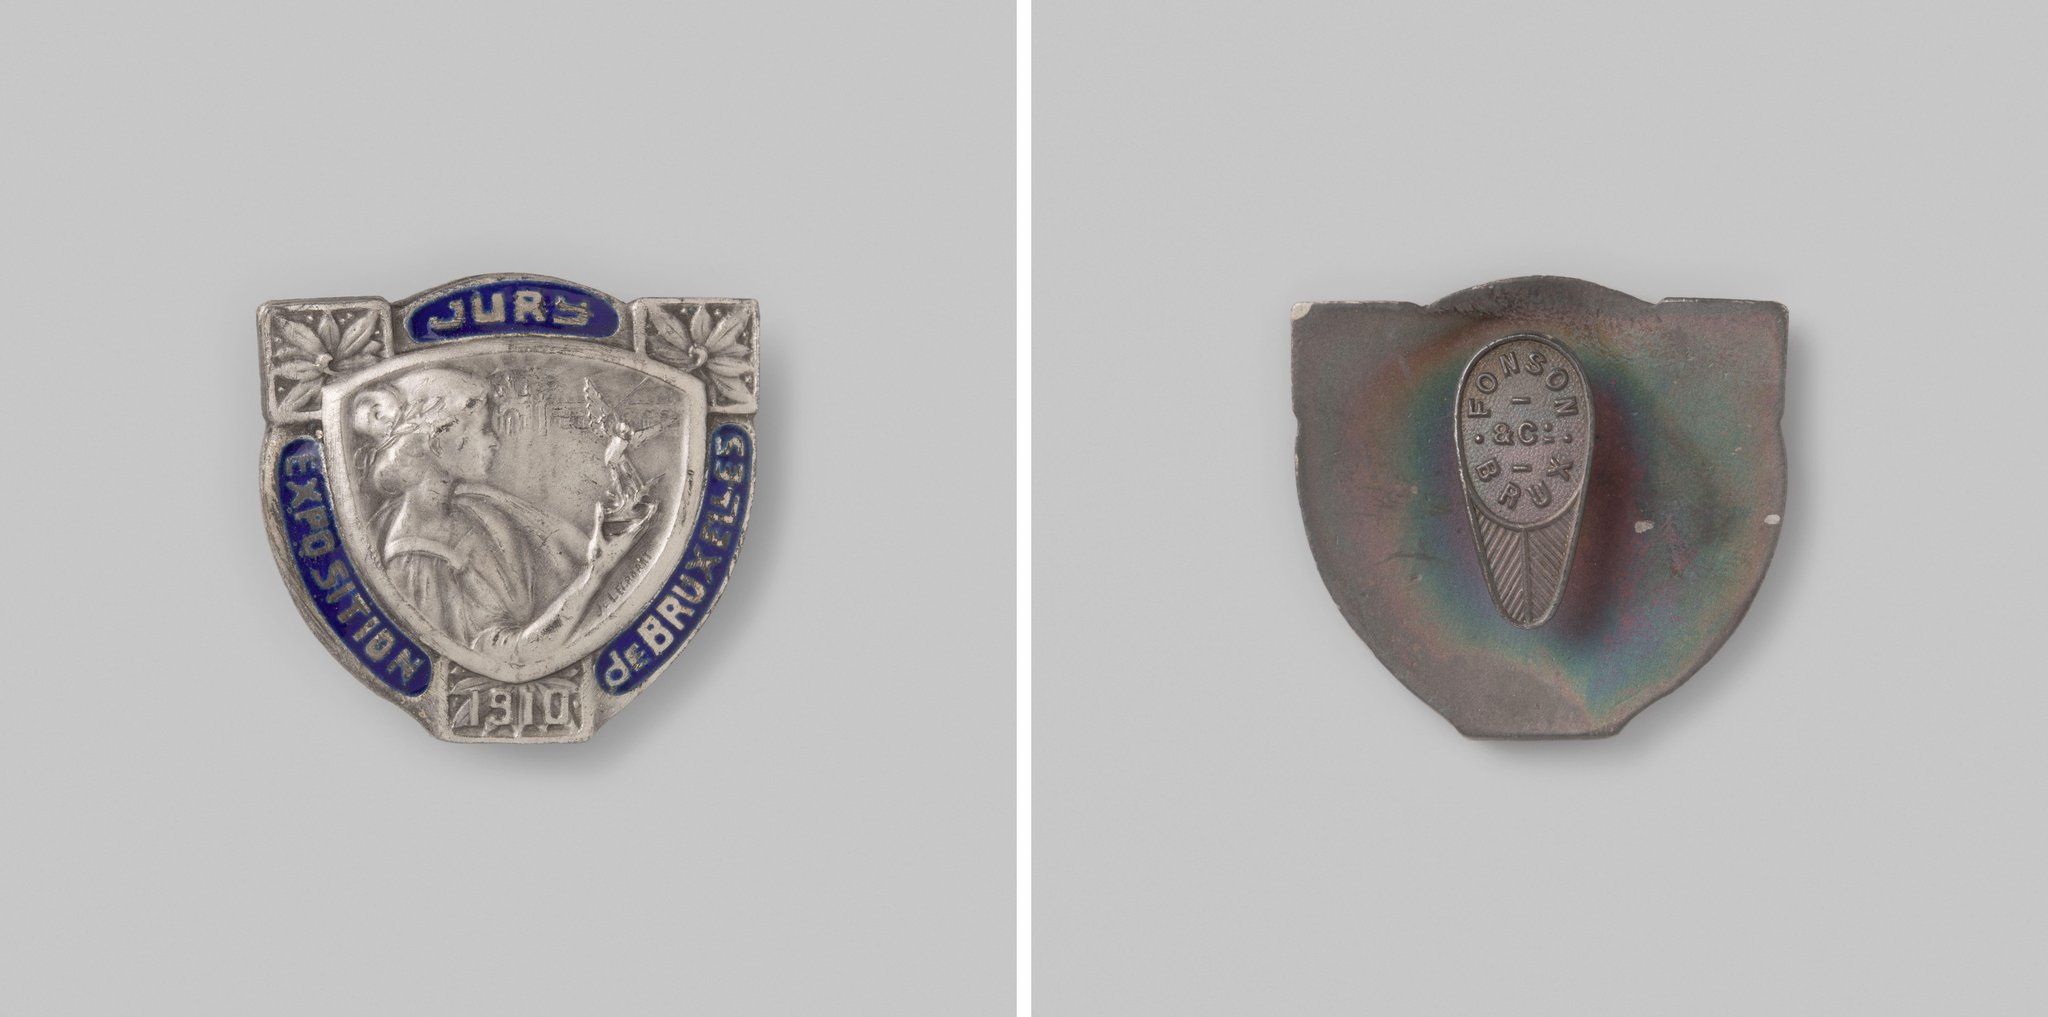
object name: insignia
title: Draagteken uitgereikt aan Bart van Hove, een van de juryleden van de Wereldtentoonstelling te Brussel, 1910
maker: jean lecroart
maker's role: medailleur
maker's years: 1883-1967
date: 1910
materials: silver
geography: belgium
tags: the hague, amsterdam, sculptor, bart van hove, brussels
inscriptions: signature: ‘J. LECROART’, inscription: ‘JURY EXPOSITION DE BRUXELLES 1910’, inscription: ‘FONSON .&c;. BRUX’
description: Penning in vorm halve ovaal. Voorzijde: in midden binnen omlijsting borstfiguur van naar rechts gekeerde vrouw in profiel die in rechterhand beeldje van gevleugelde ridder (Sint Joris) vasthoudt, met op de achtergrond een gebouw; in bovenhoeken bloemmotief, onder jaartal in cartouche, boven- en zijkanten in zilveren letters op blauwe achtergrond omschrift. Keerzijde: leeg met bevestiging (bedoeld voor knoopsgat) waarop merk.